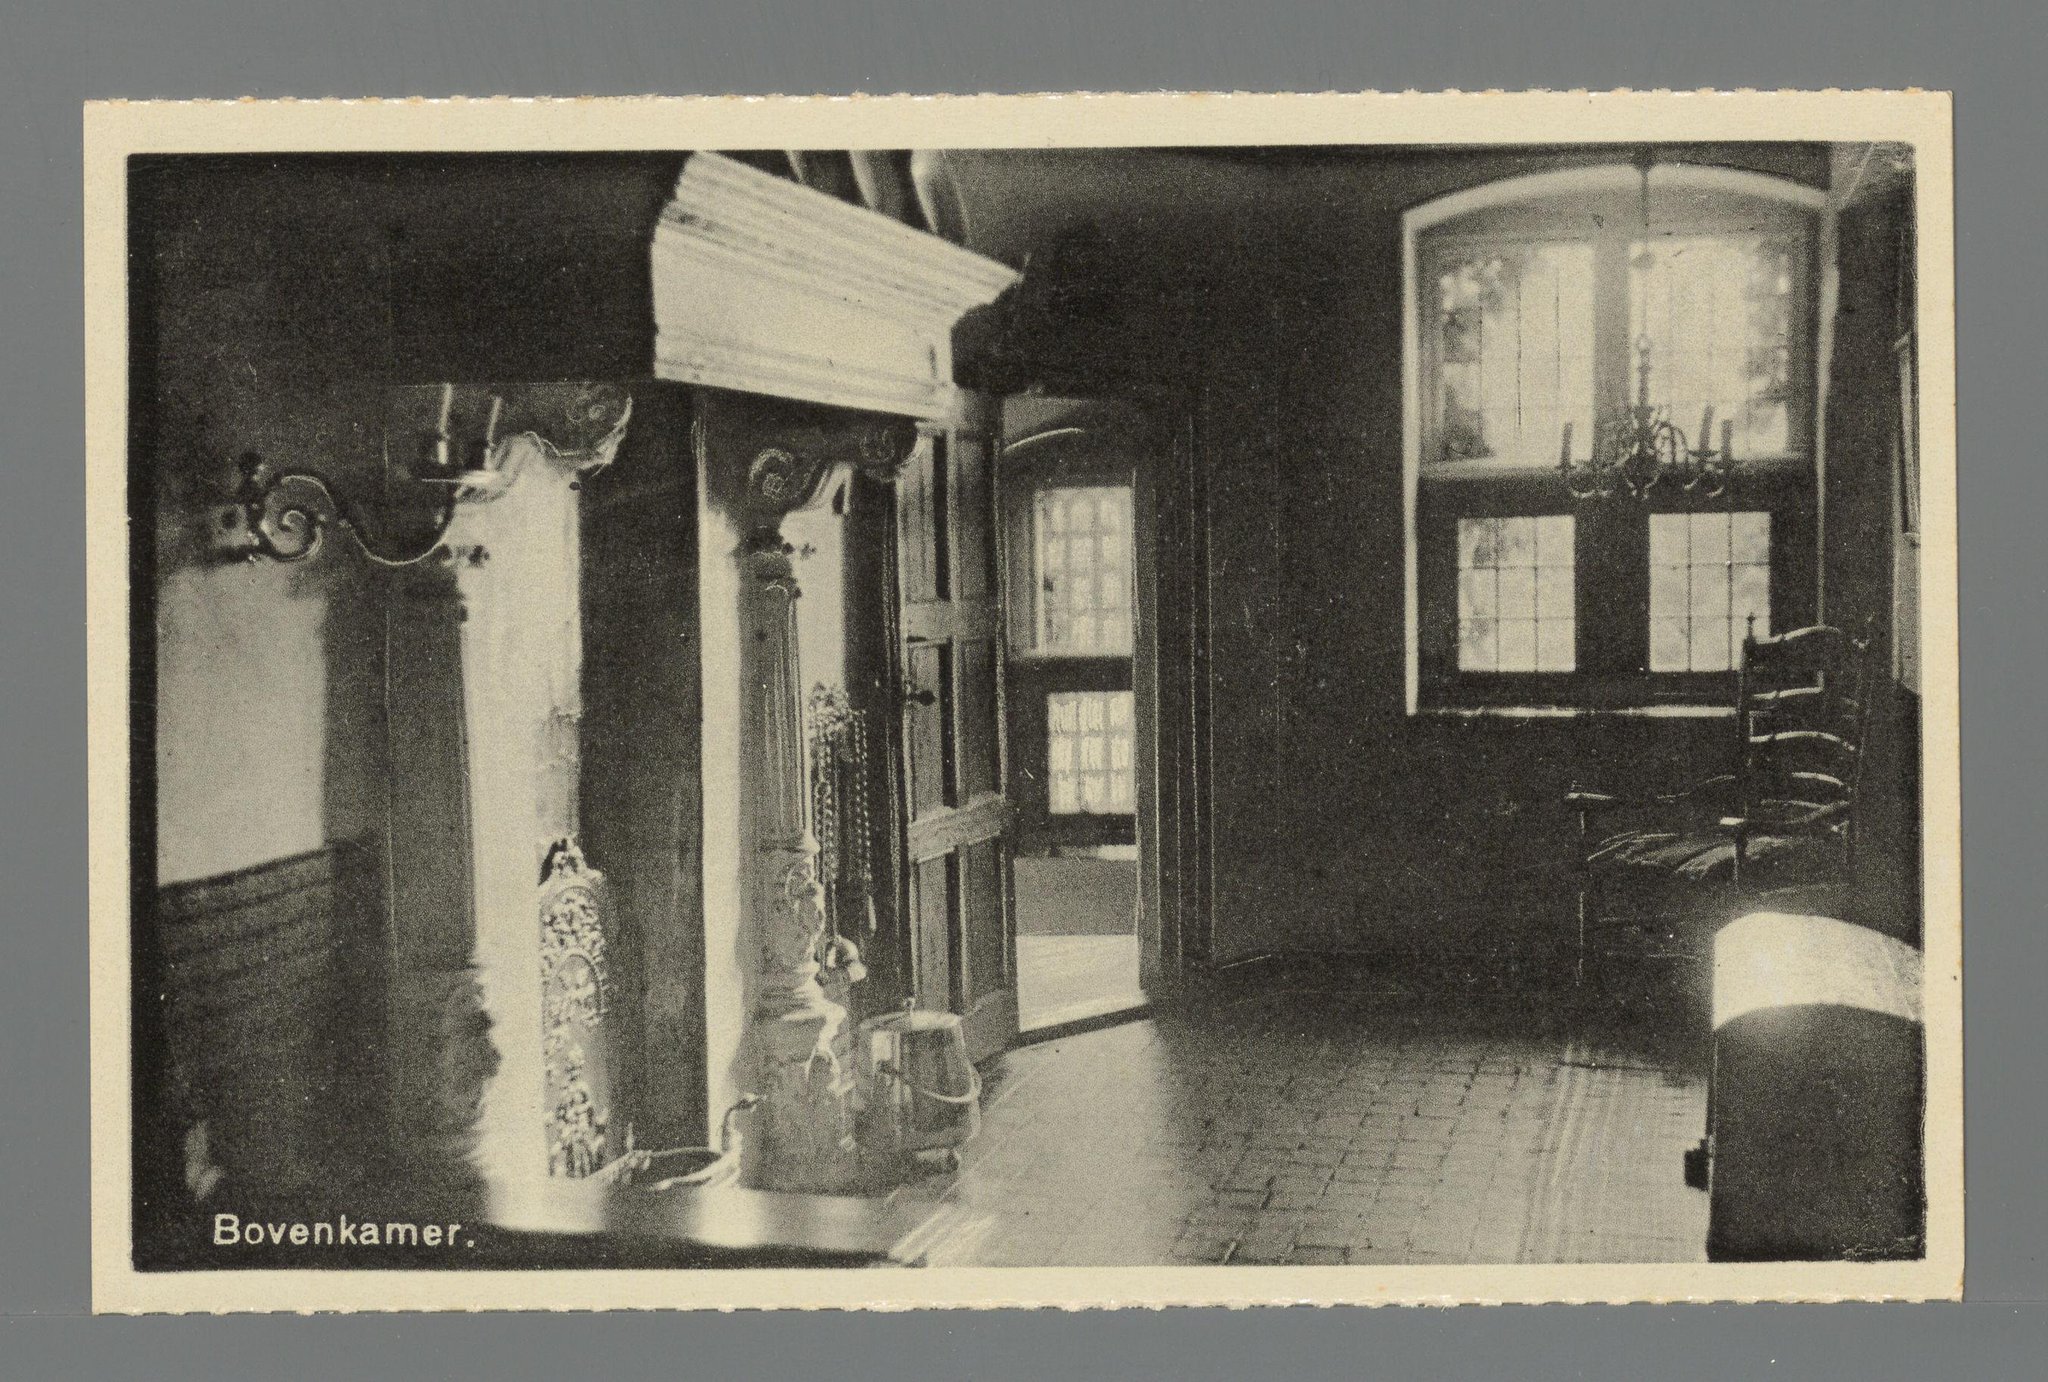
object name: photomechanical print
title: Bovenkamer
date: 1913-1950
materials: cardboard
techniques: photograph, writing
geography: marssum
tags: open hearth, fire-place, permanent exhibition, museum